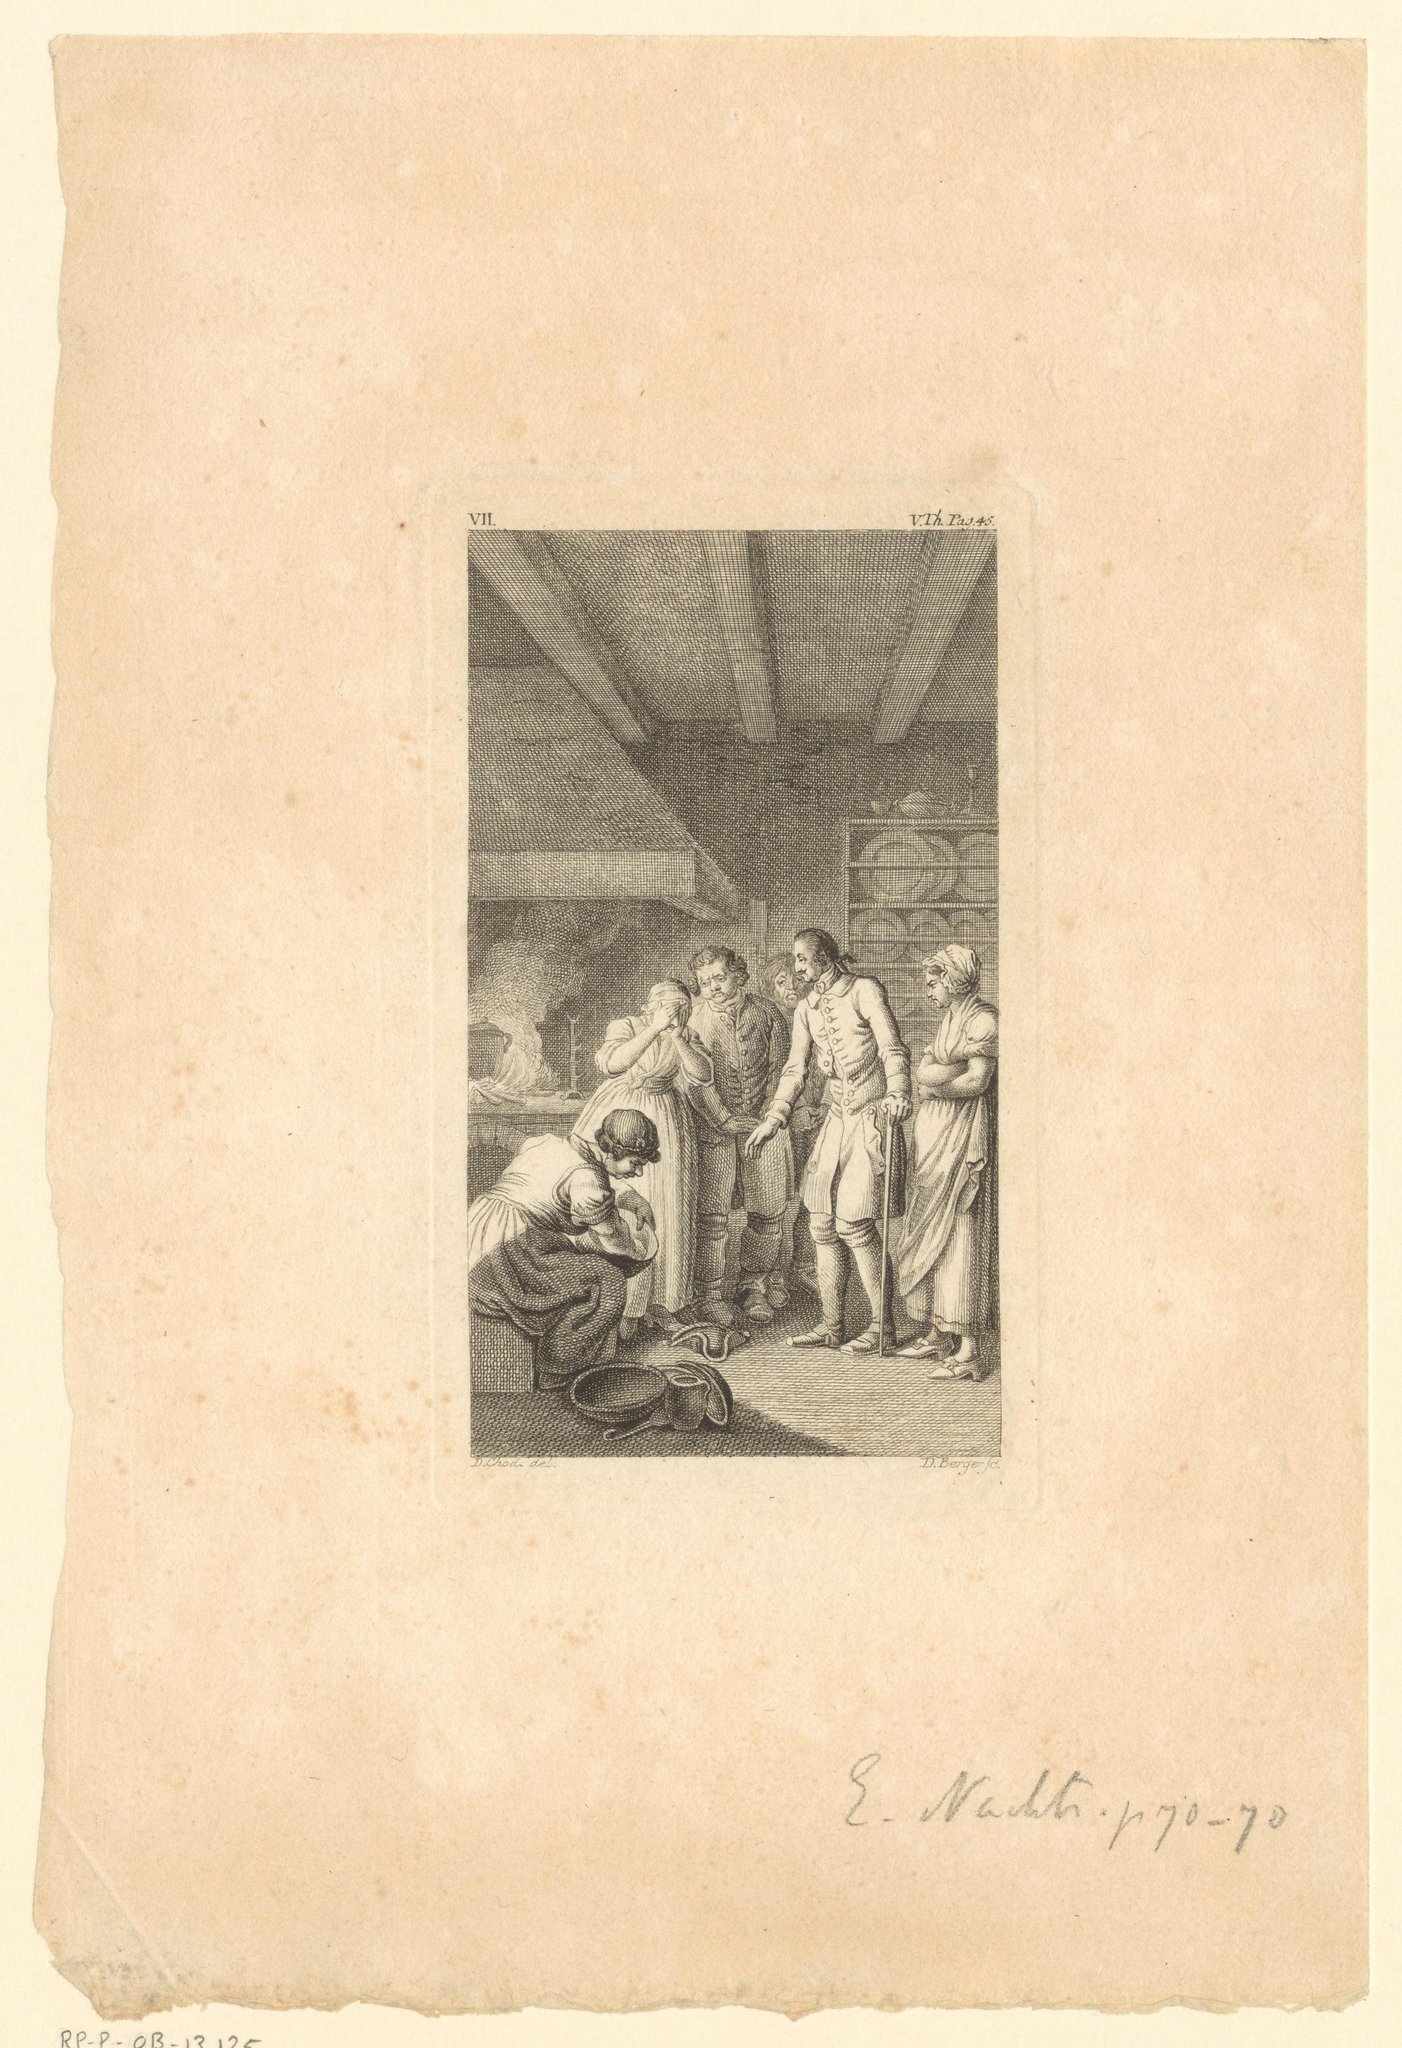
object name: print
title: XII Kupfer zu den Leben und Meynungen Tristram Shandy's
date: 1778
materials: paper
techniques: etching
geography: berlin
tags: london, clergyman, kitchen, literary characters and objects, house personnel, servants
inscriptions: collector's mark: Lugt 240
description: Zevende prent uit de serie 'XII Kupfer zu den Leben und Meynungen Tristram Shandy's', bestaand uit een titelpagina en 12 prenten, gedrukt op kosten van de Berlijnse boekhandelaar Christian Friedrich Himburg in 1778. De illustraties volgen een eerder verschenen tekstuitgave: [Stern, Laurence]. Tristram Schandis Leben und Meynungen [uit het Duits vertaald door] Johann Joachim Christoph Bode. 9 dln. Hamburg: Carl Ernst Bohn te Hamburg, 1776.